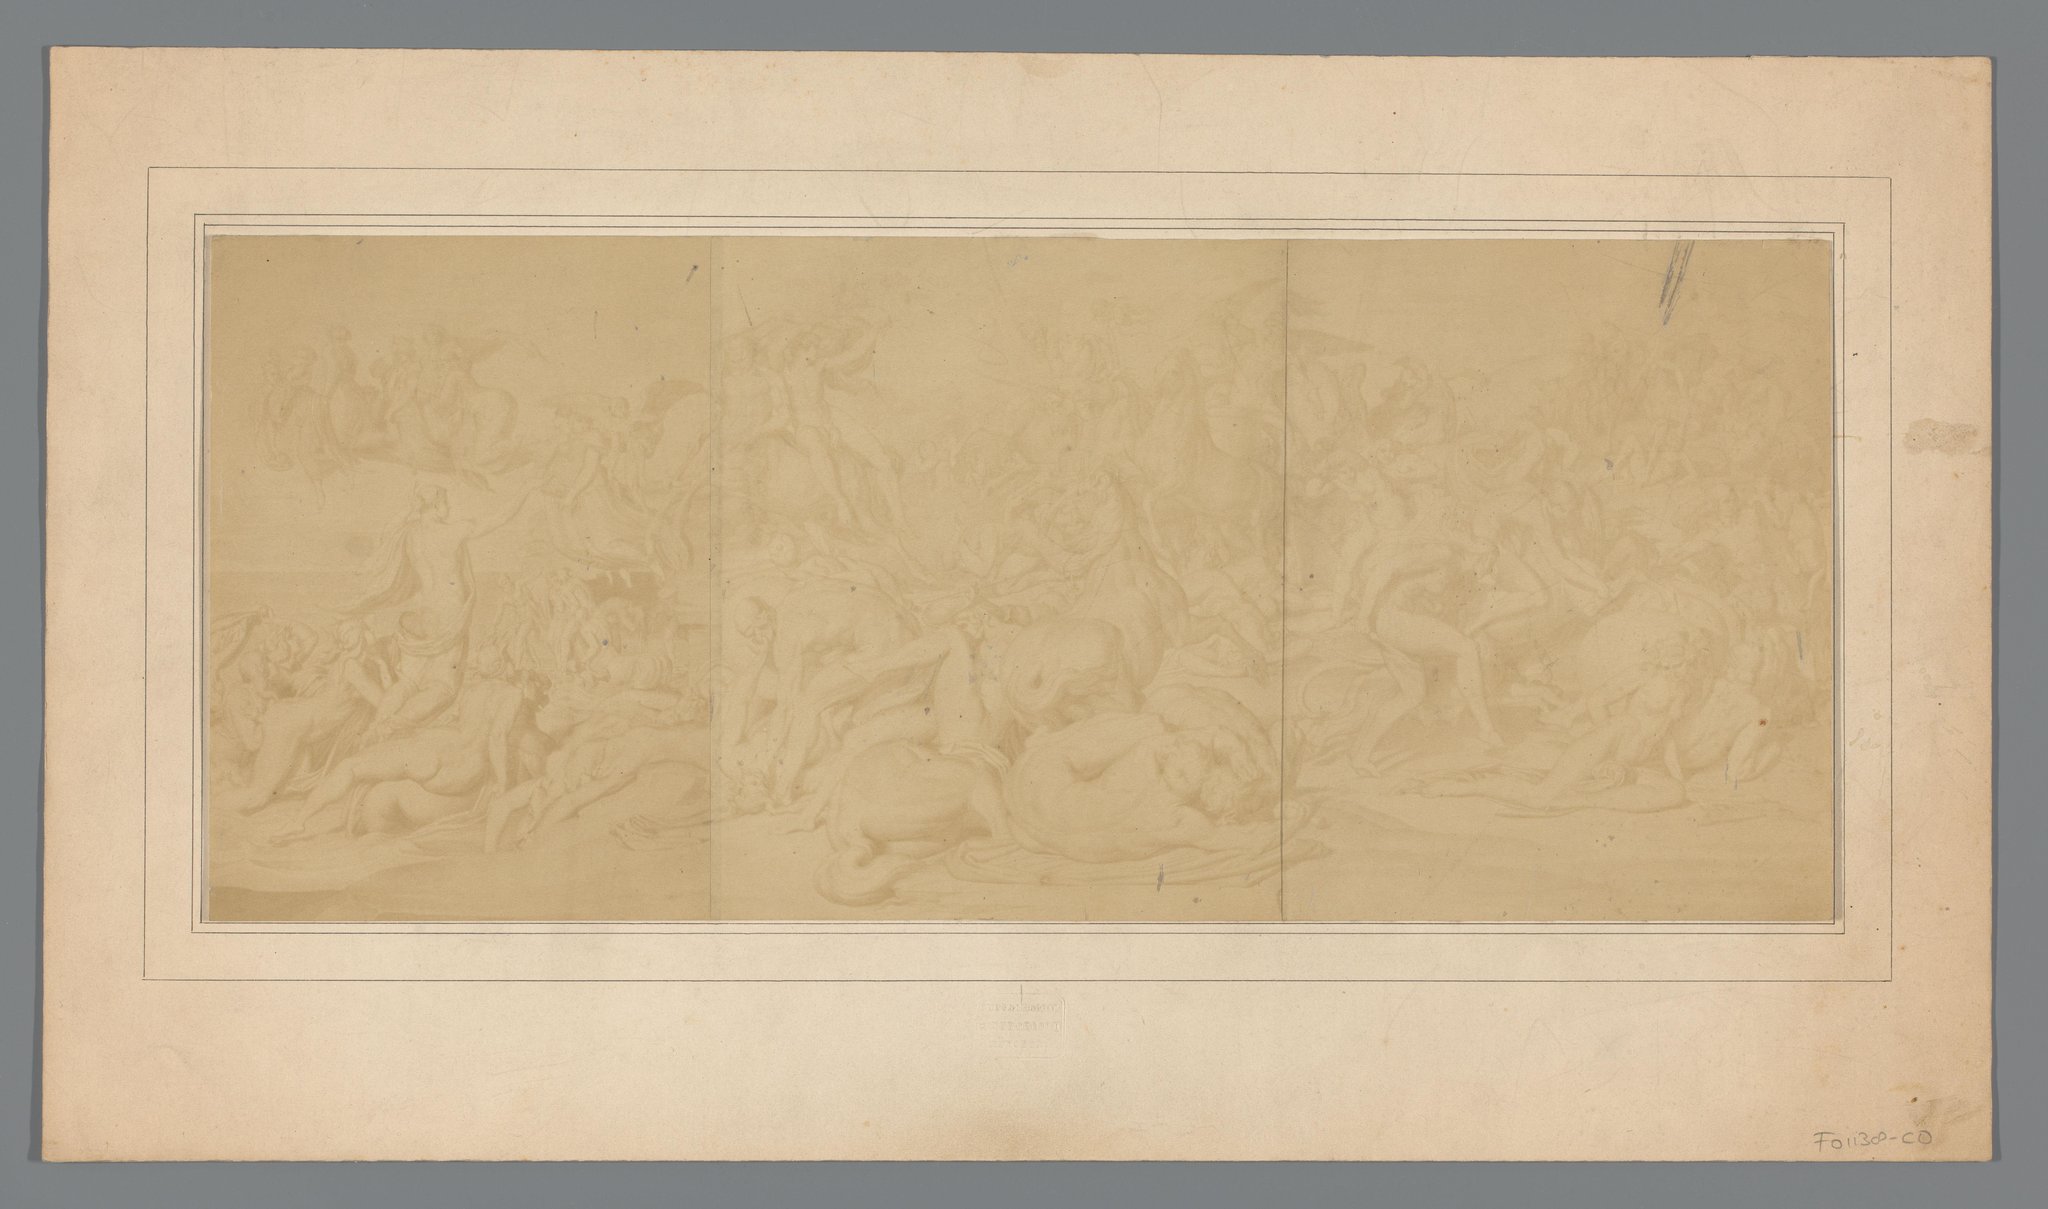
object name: photograph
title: Fotoreproductie van (vermoedelijk) een tekening, voorstellend goden, mensen en paarden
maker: e.w. froelich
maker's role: fotograaf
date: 1860-1900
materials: photographic support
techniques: albumen print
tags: primeval deities, elementary gods ~ classical mythology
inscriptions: name: ‘Photographie [...].W.Froelich München’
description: Foto bestaande uit drie aan elkaar geplakte afdrukken. Onderdeel van Reisalbum met opnames van kunstwerken en bezienswaardigheden in Italië, Griekenland en Frankrijk.